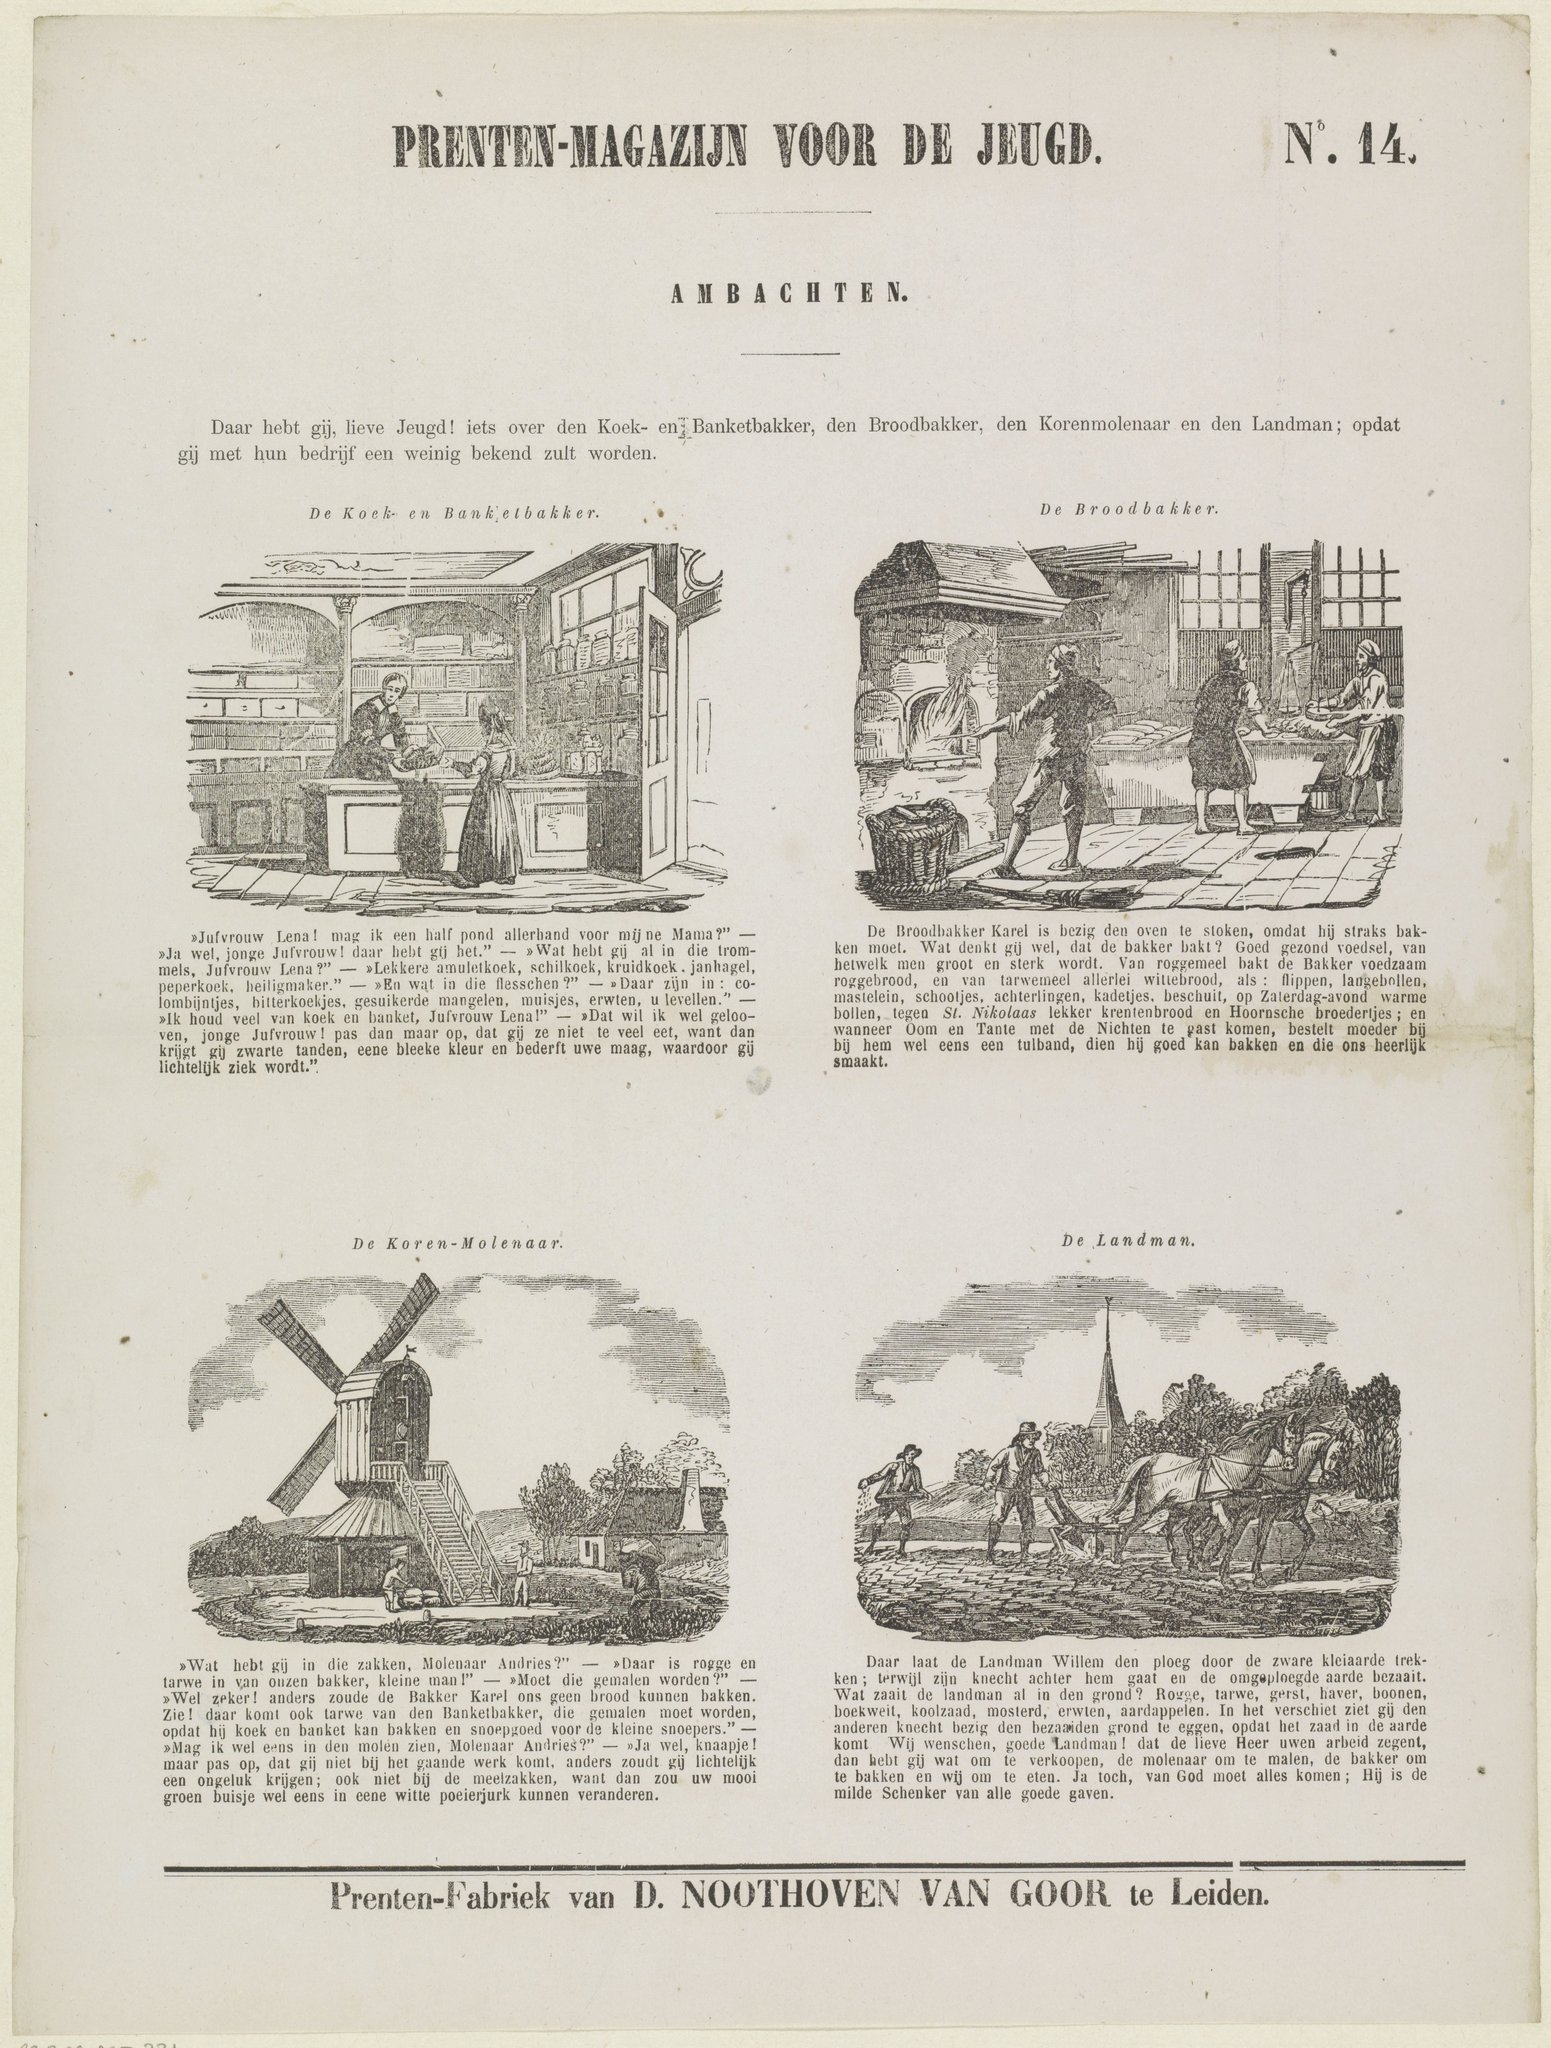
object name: print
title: Ambachten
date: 1850-1881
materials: paper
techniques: letterpress printing, engraving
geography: leiden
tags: miller, farmers, baker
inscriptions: collector's mark: Lugt 2760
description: Blad met 4 voorstellingen van ambachtslieden: een koek- en banketbakker, een broodbakker, een molenaar en een boer. Boven elke voorstelling een titel en onder elke voorstelling negen tot tien regels tekst. Genummerd rechtsboven: No. 14.